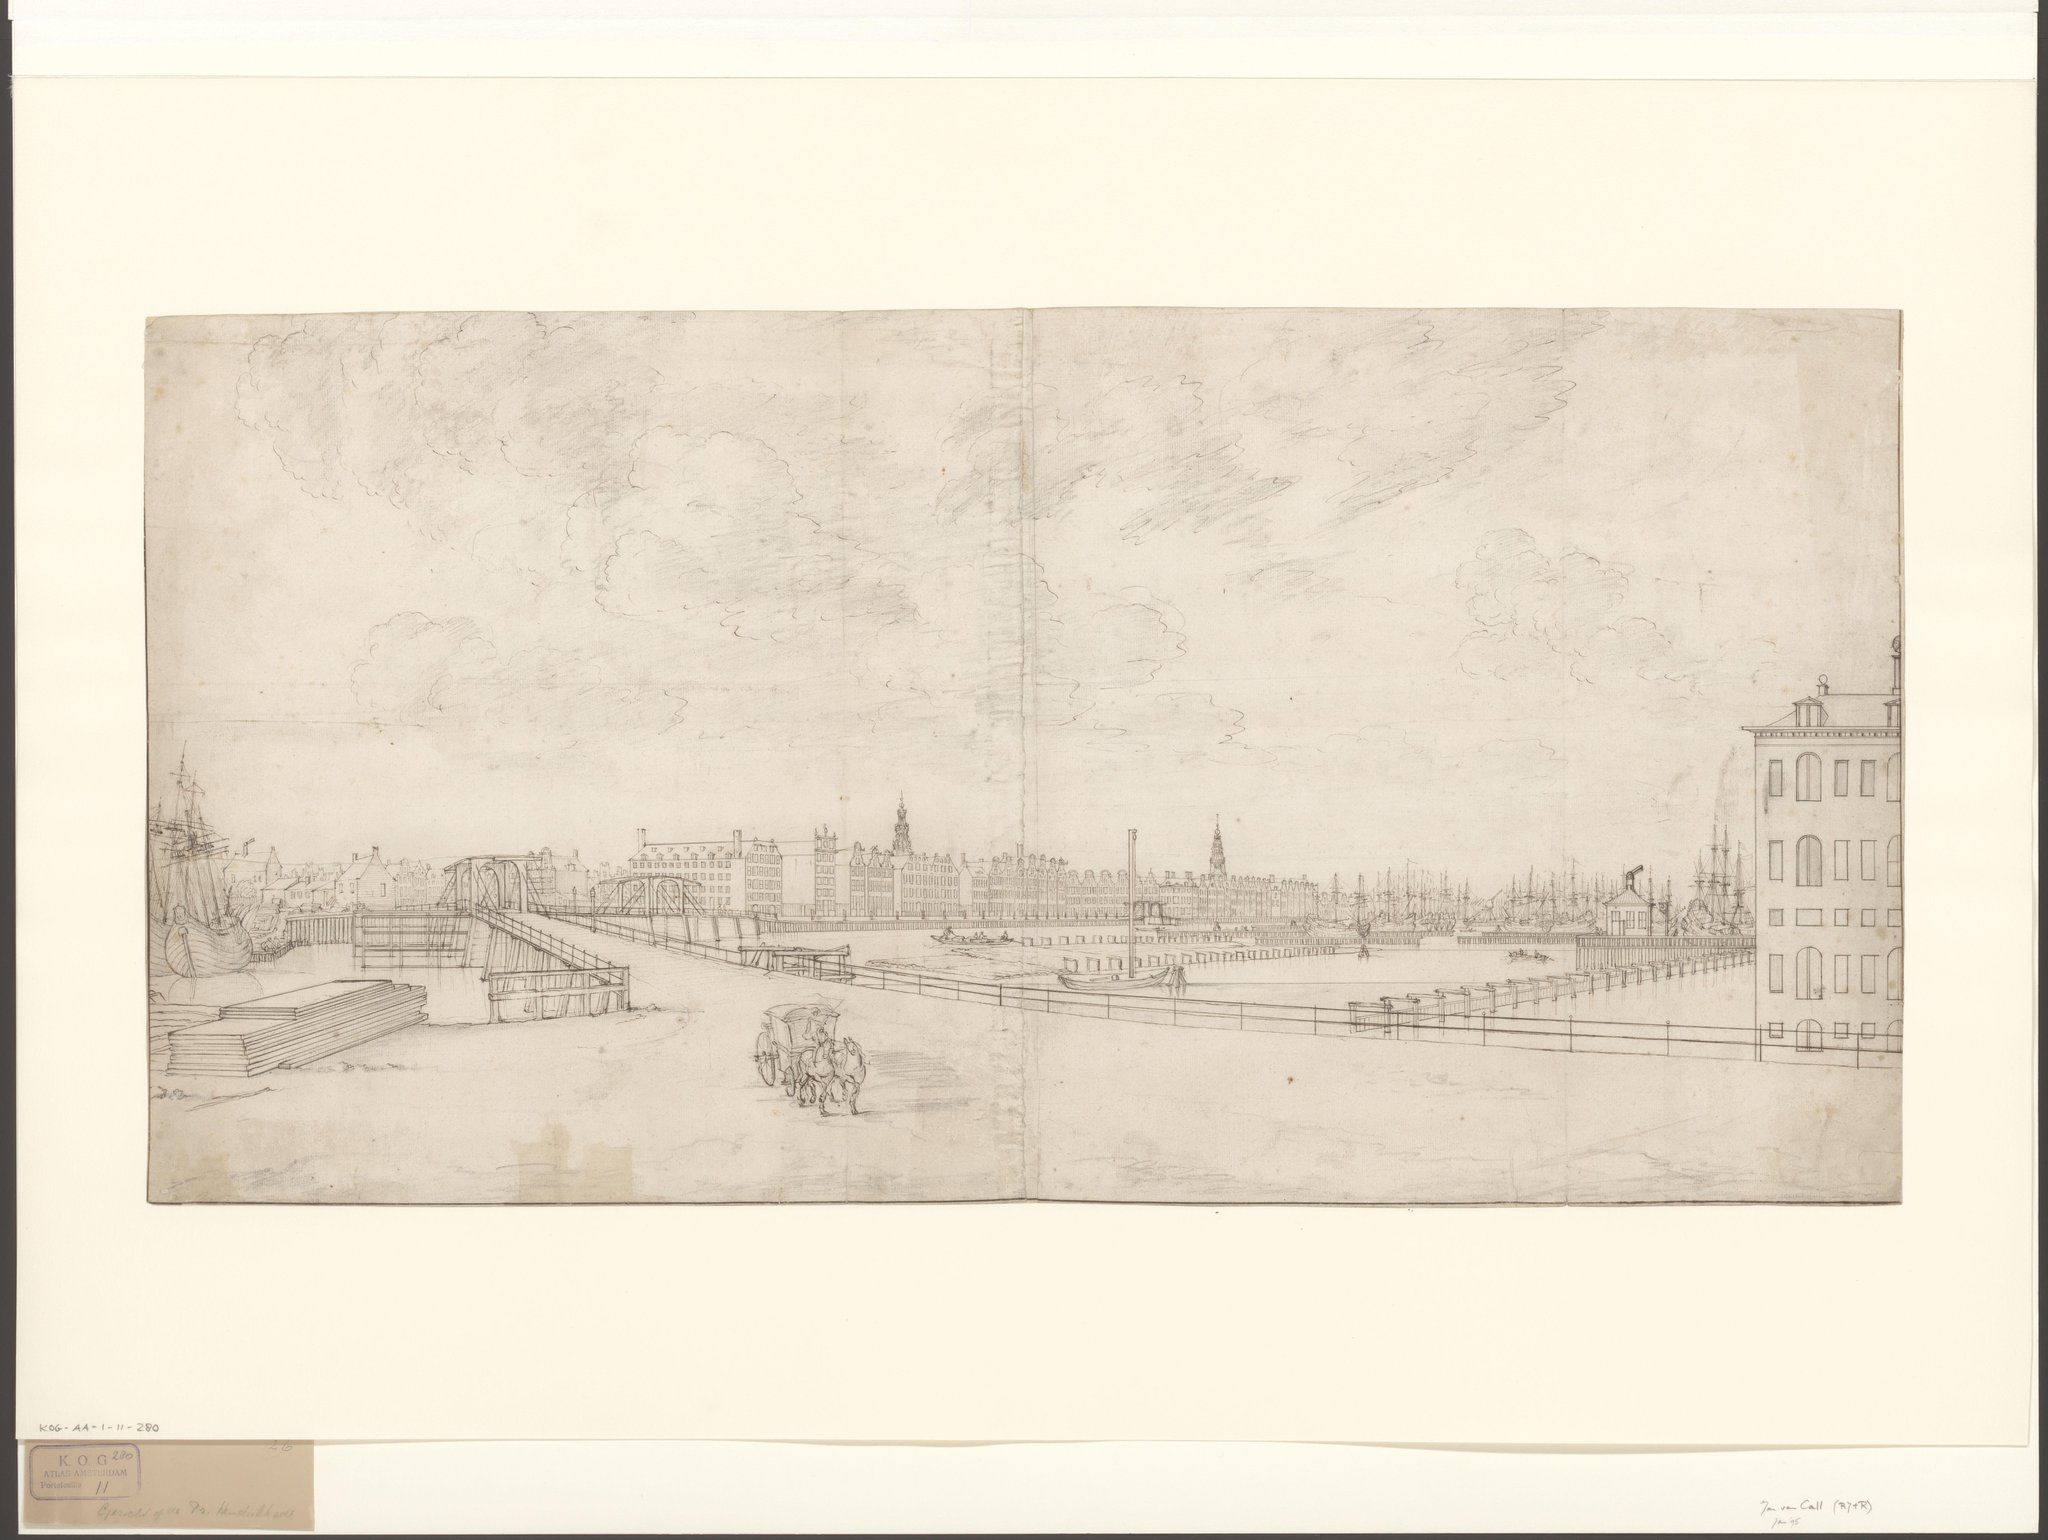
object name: drawing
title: Gezicht op de Prins Hendrikkade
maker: jan van call (i)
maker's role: draughtsman, print maker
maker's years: 1656-1706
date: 1666-1706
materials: ink, paper, pencil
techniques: pen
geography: amsterdam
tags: city-view in general; 'veduta', canal, the usual house or row of houses, four-wheeled vehicle drawn by two animals, street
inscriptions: inscription: ‘Gezicht op de Pr. Hendrikkade’, collector's mark: ‘11 / 280’ Lugt 1641b, inscription: ‘Port. 11-280’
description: Onderwerpsrubriek binnen de Atlas Amsterdam: Prinsengracht, Korte Prinsengracht, Prins Hendrikkade. Zie ook Portefeuille 1: gezichten van het IJ op de stad.